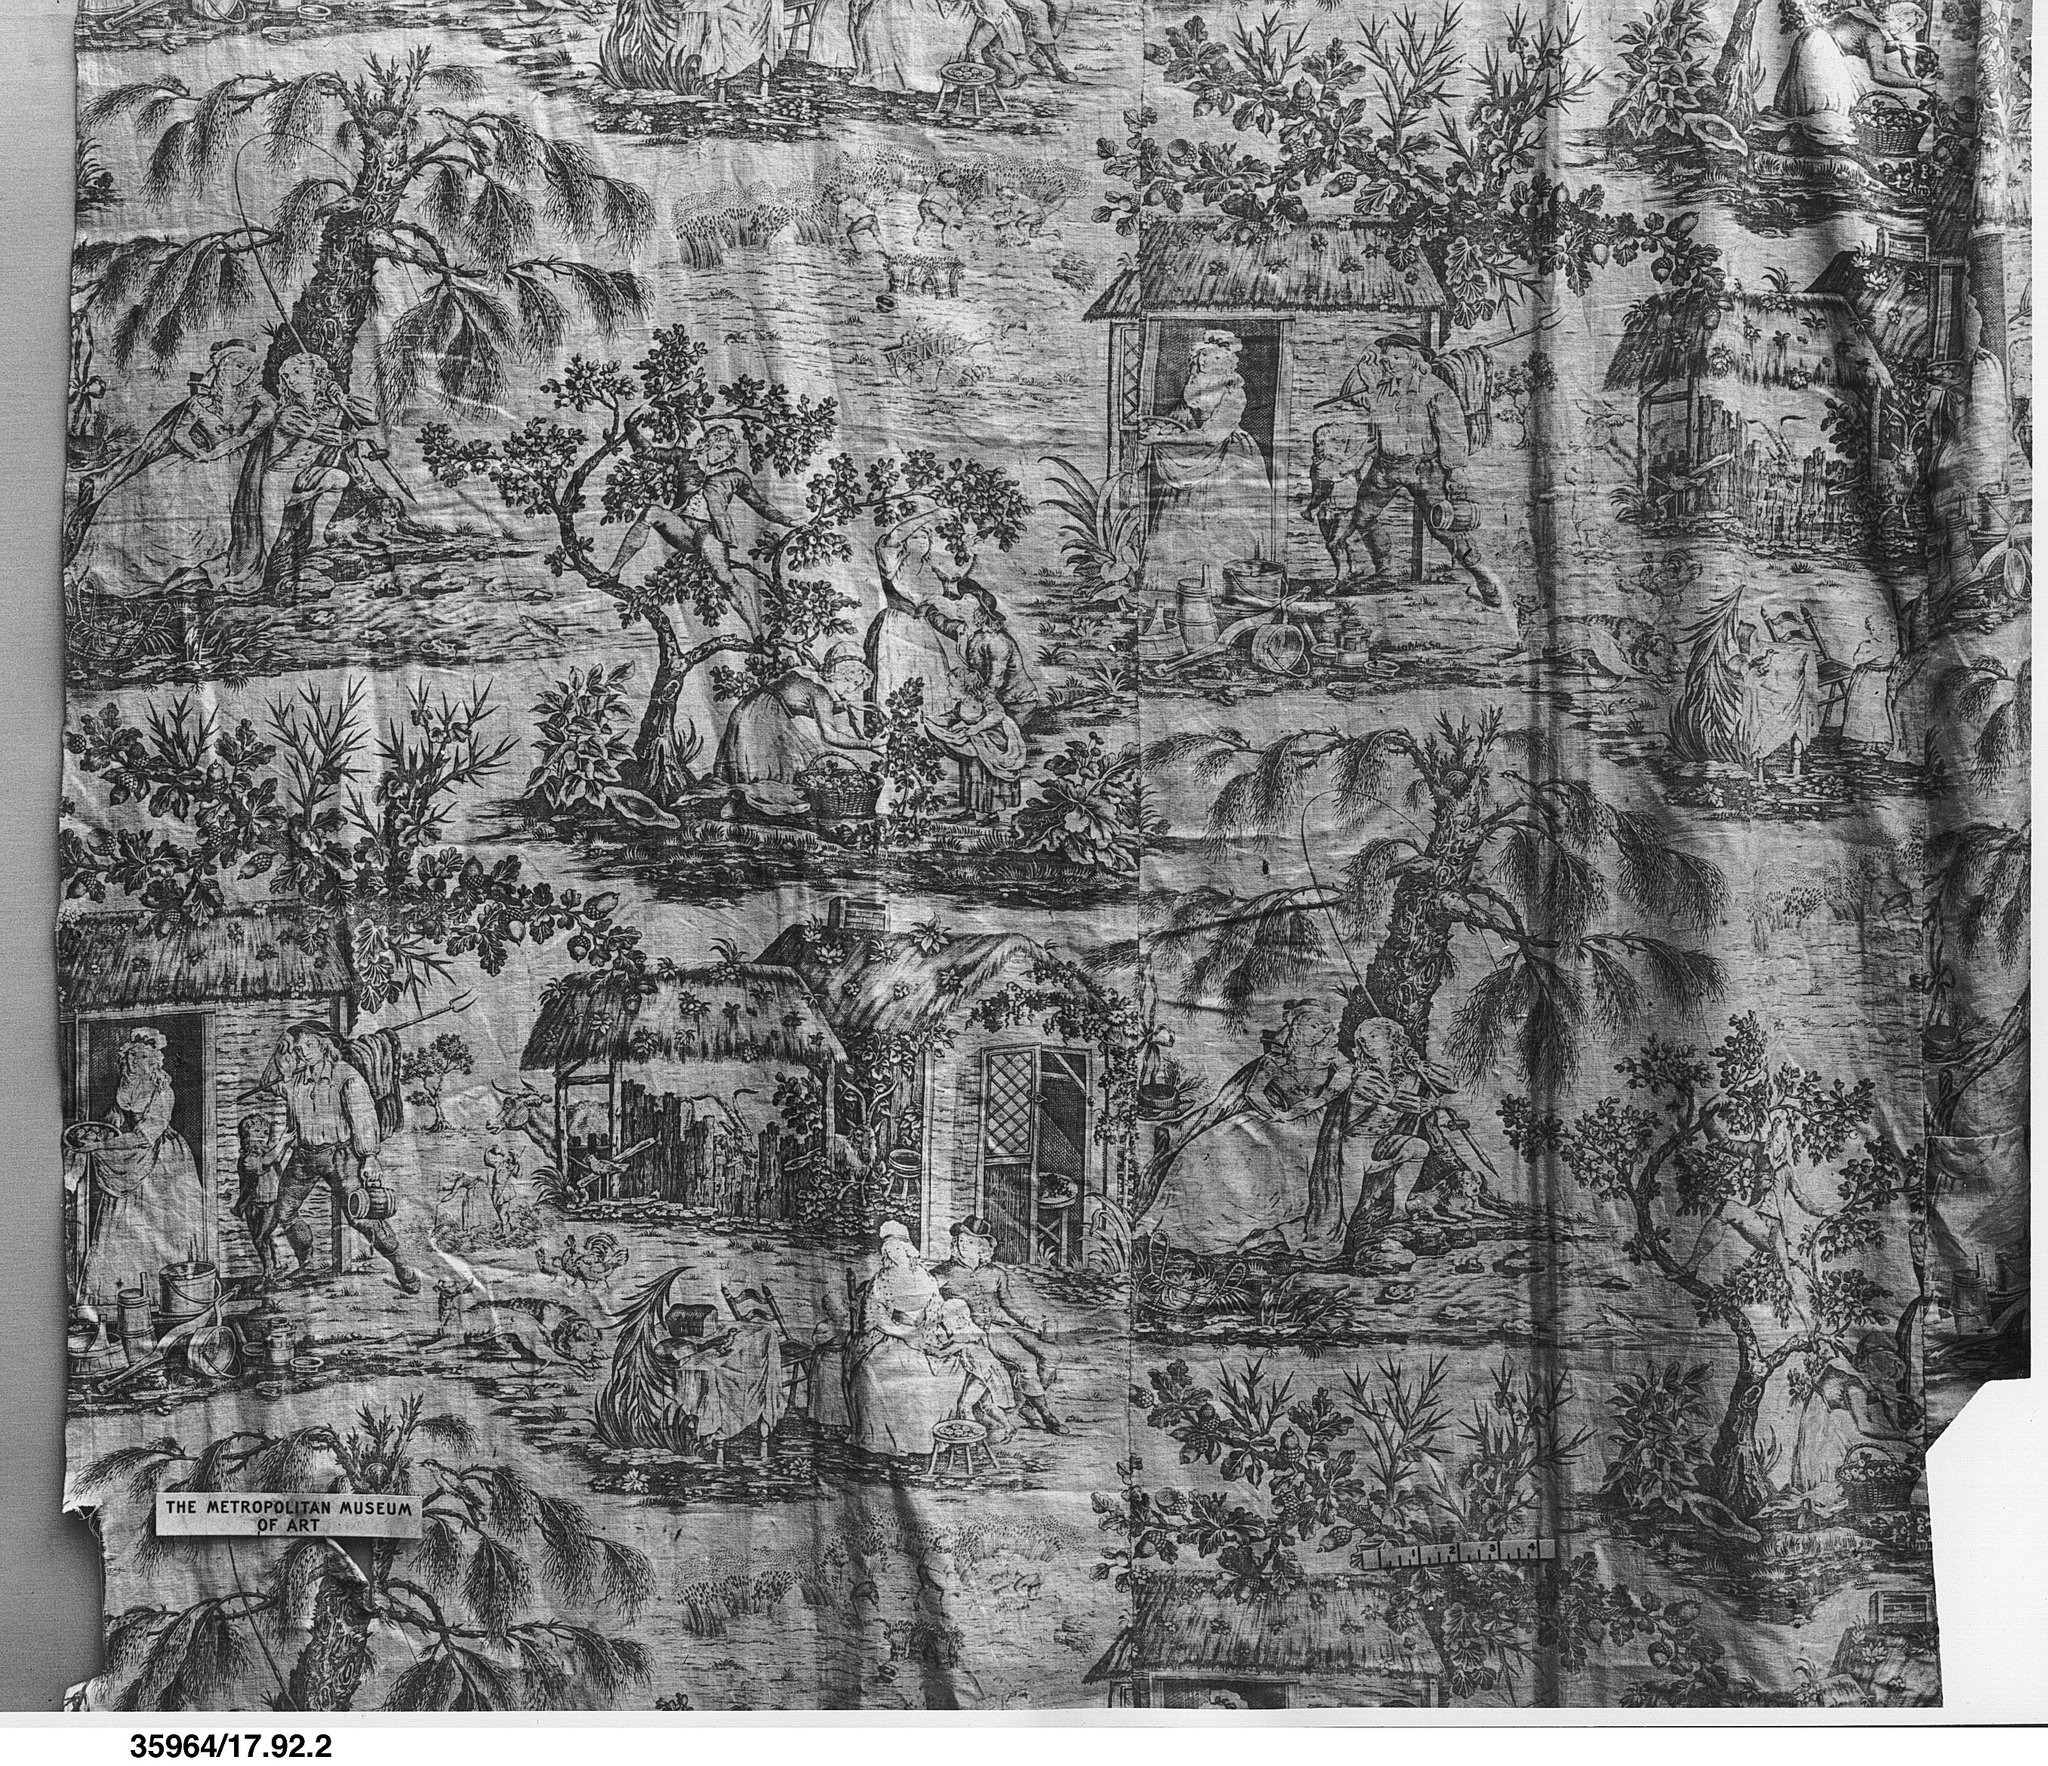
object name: furnishing textile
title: Pictorial print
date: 1790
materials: cotton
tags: houses,men,women,trees